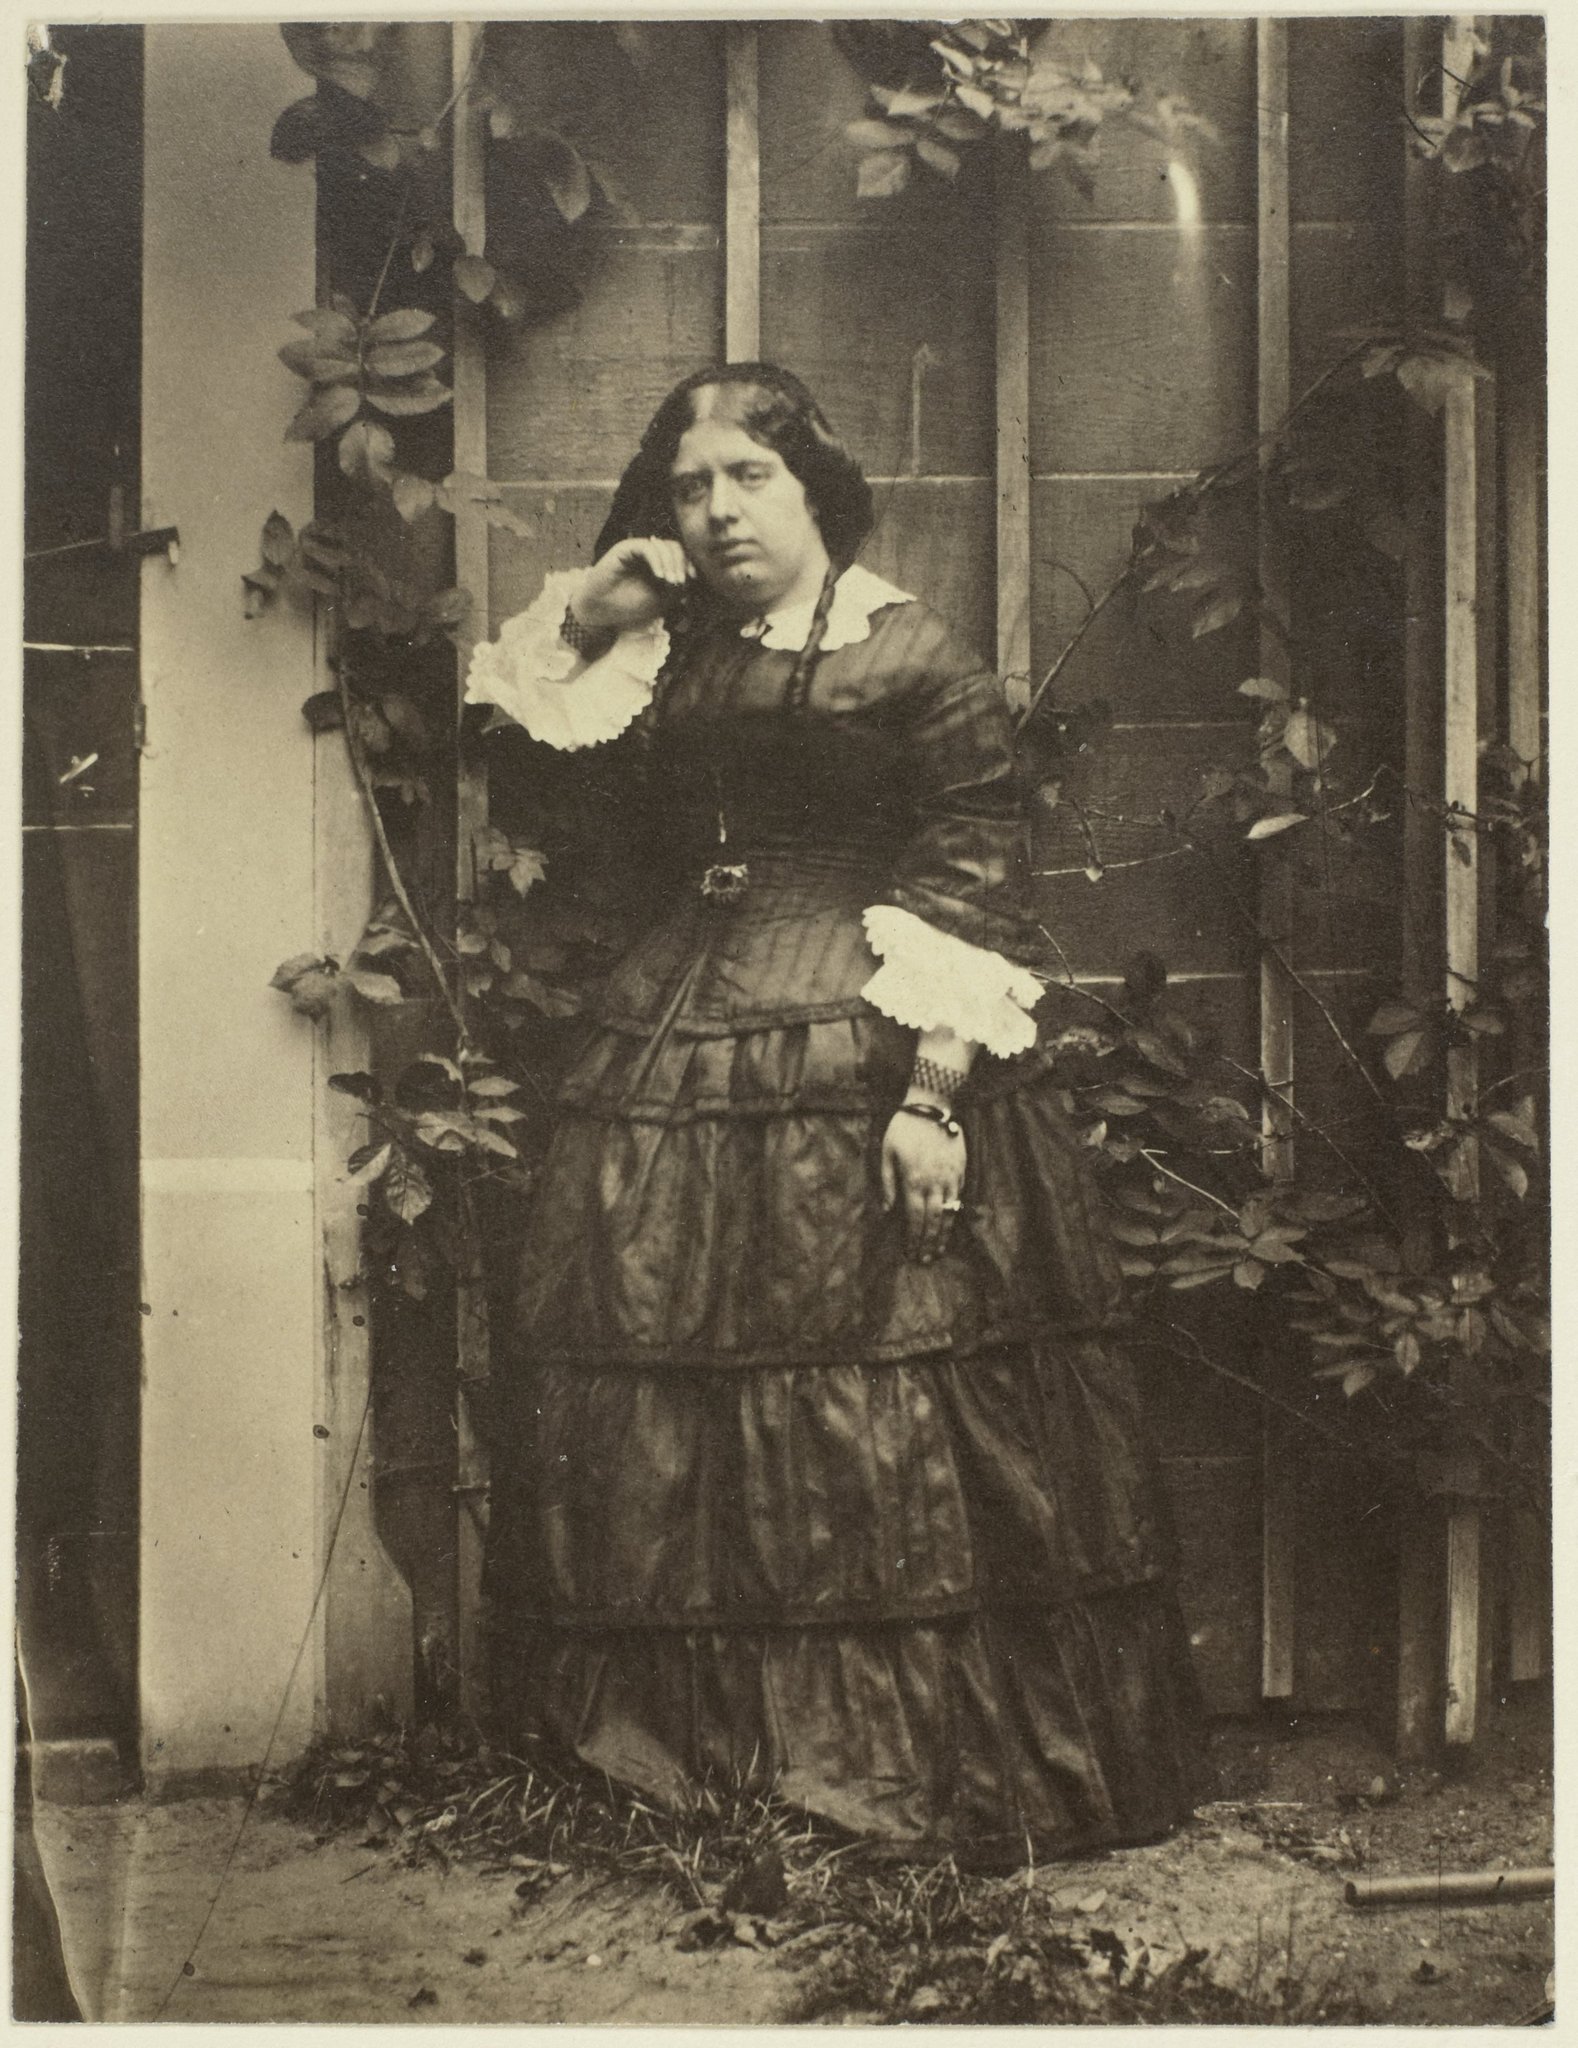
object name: photograph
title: Portret van Caroline Asser in een tuin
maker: eduard isaac asser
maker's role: amateurfotograaf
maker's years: 1809-1894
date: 1853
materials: cardboard, paper, photographic support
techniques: salted paper print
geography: amsterdam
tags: historical persons - bb - woman